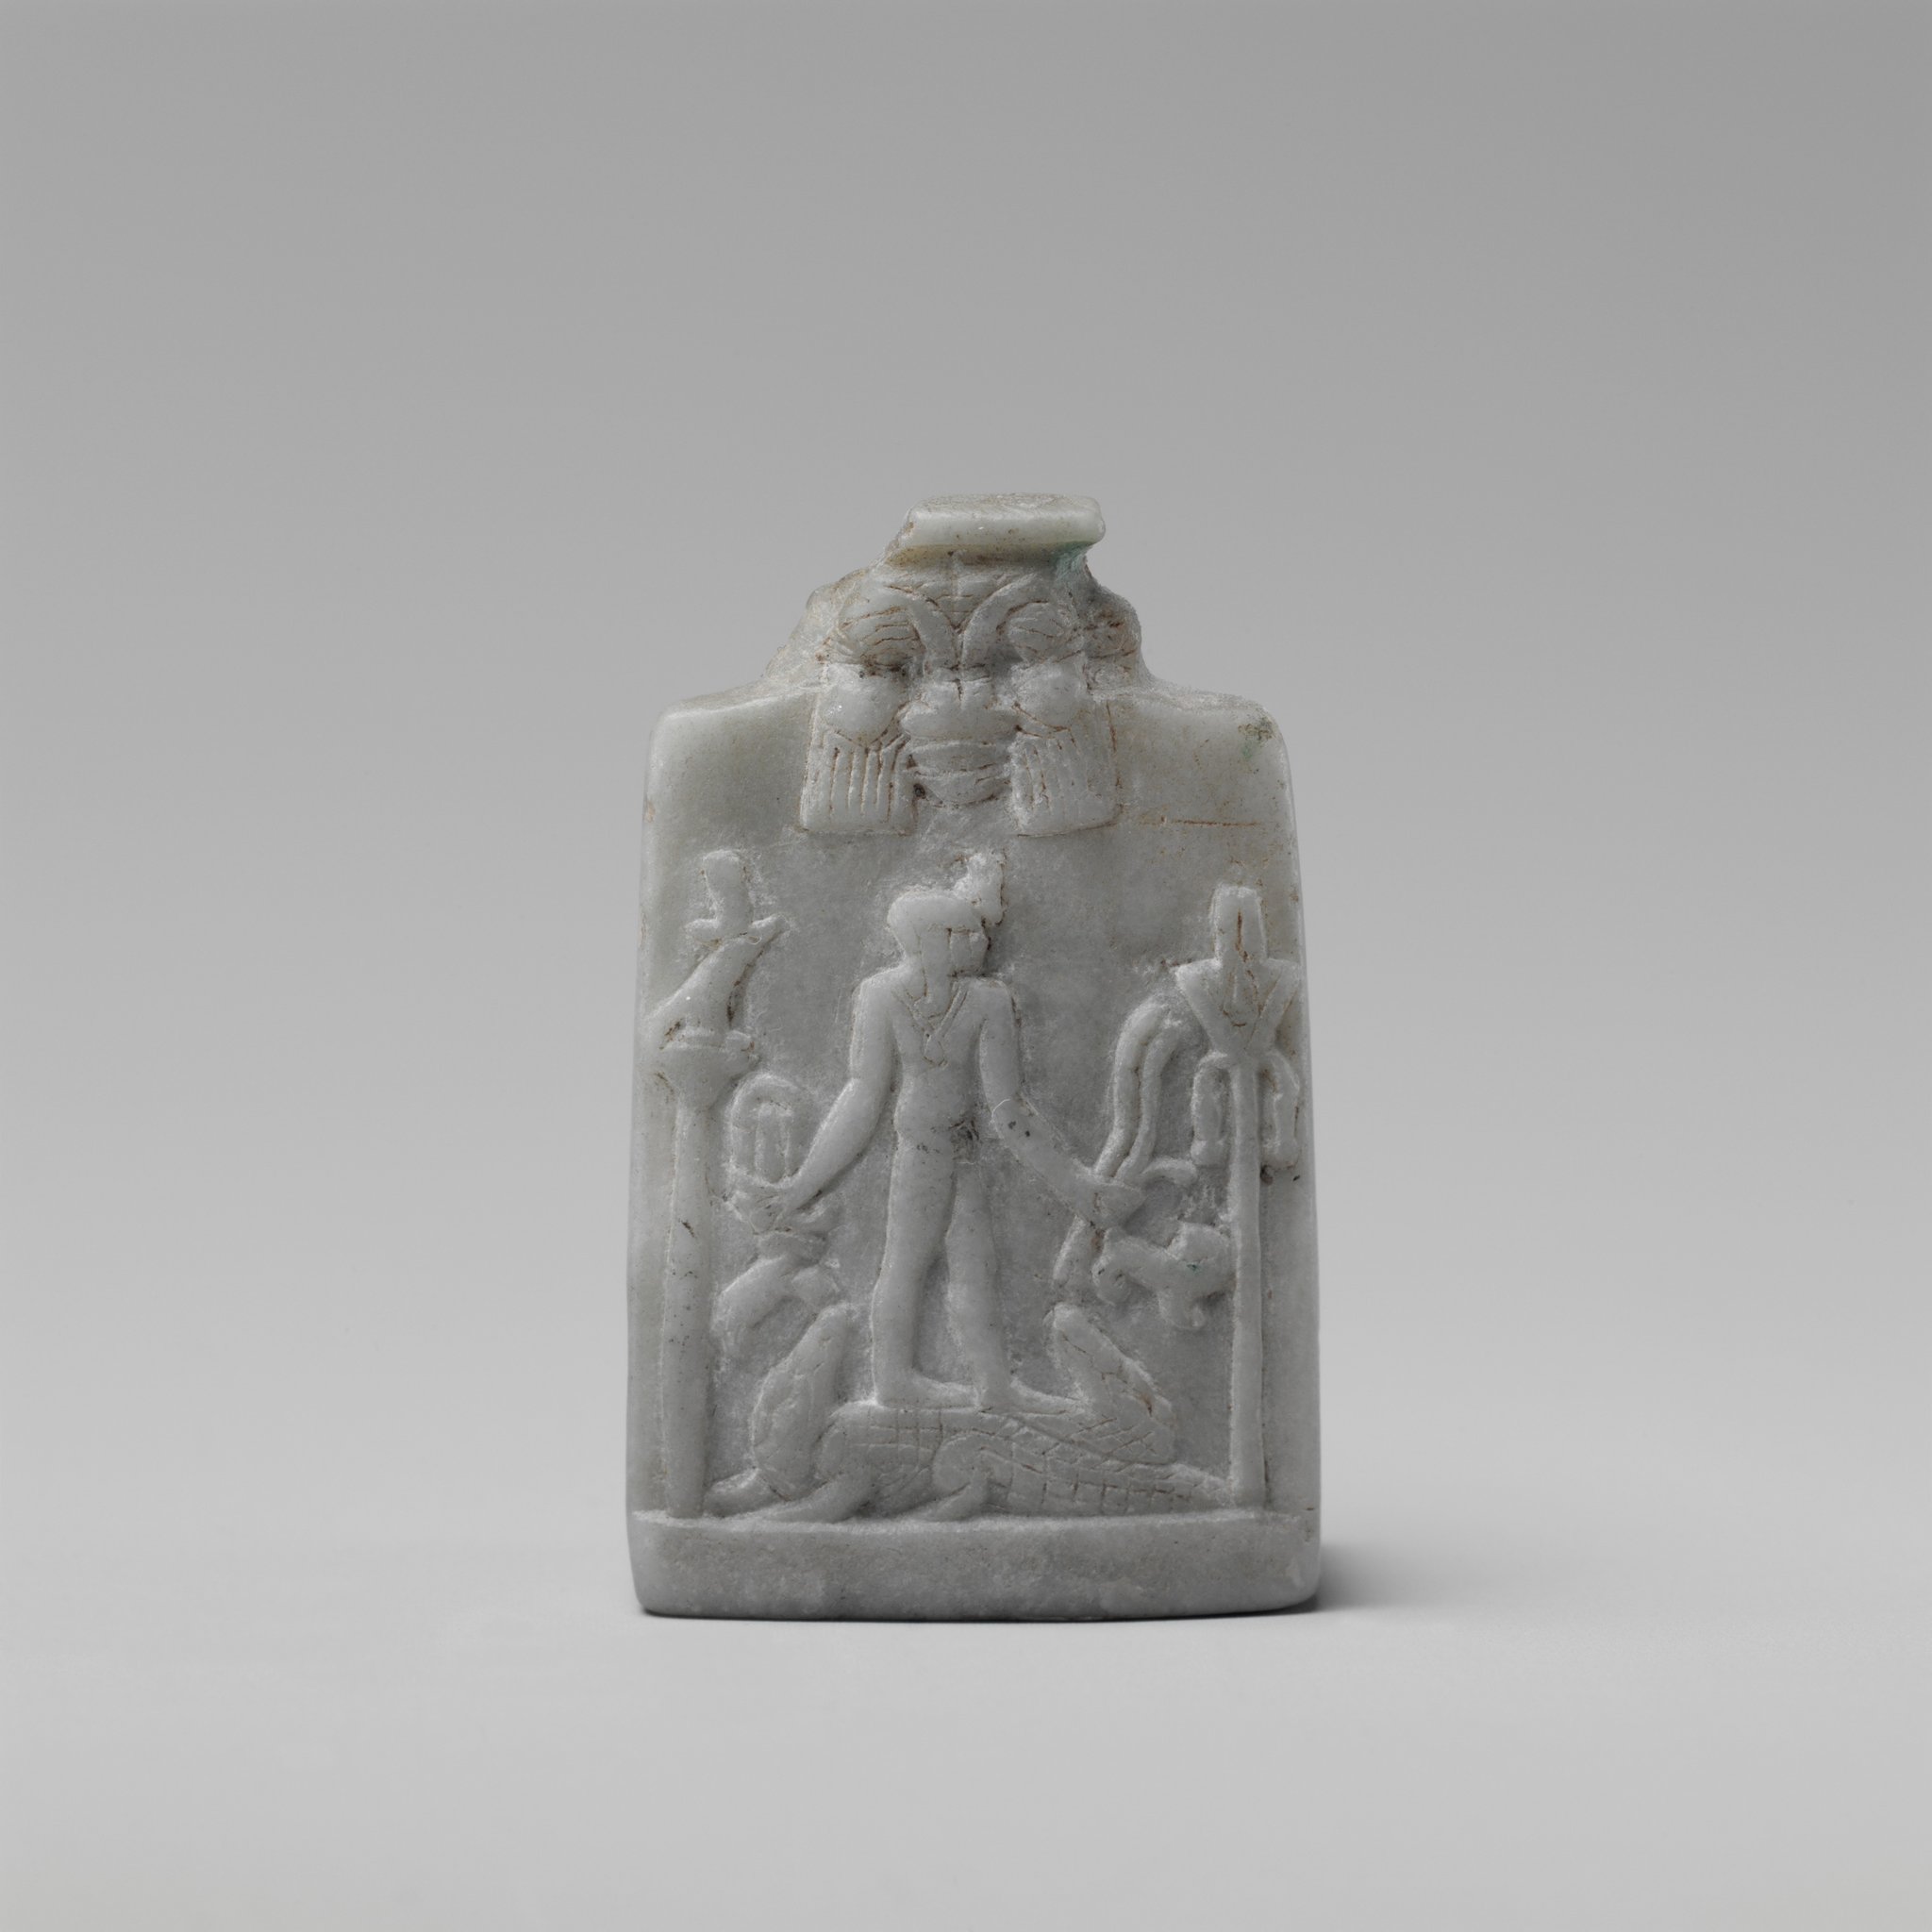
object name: amulet, cippus, profile horus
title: Miniature Cippus (magical stela) with Horus in profile wearing gazelle head on the forehead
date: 712-332 BCE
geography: egypt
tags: horus,crocodiles